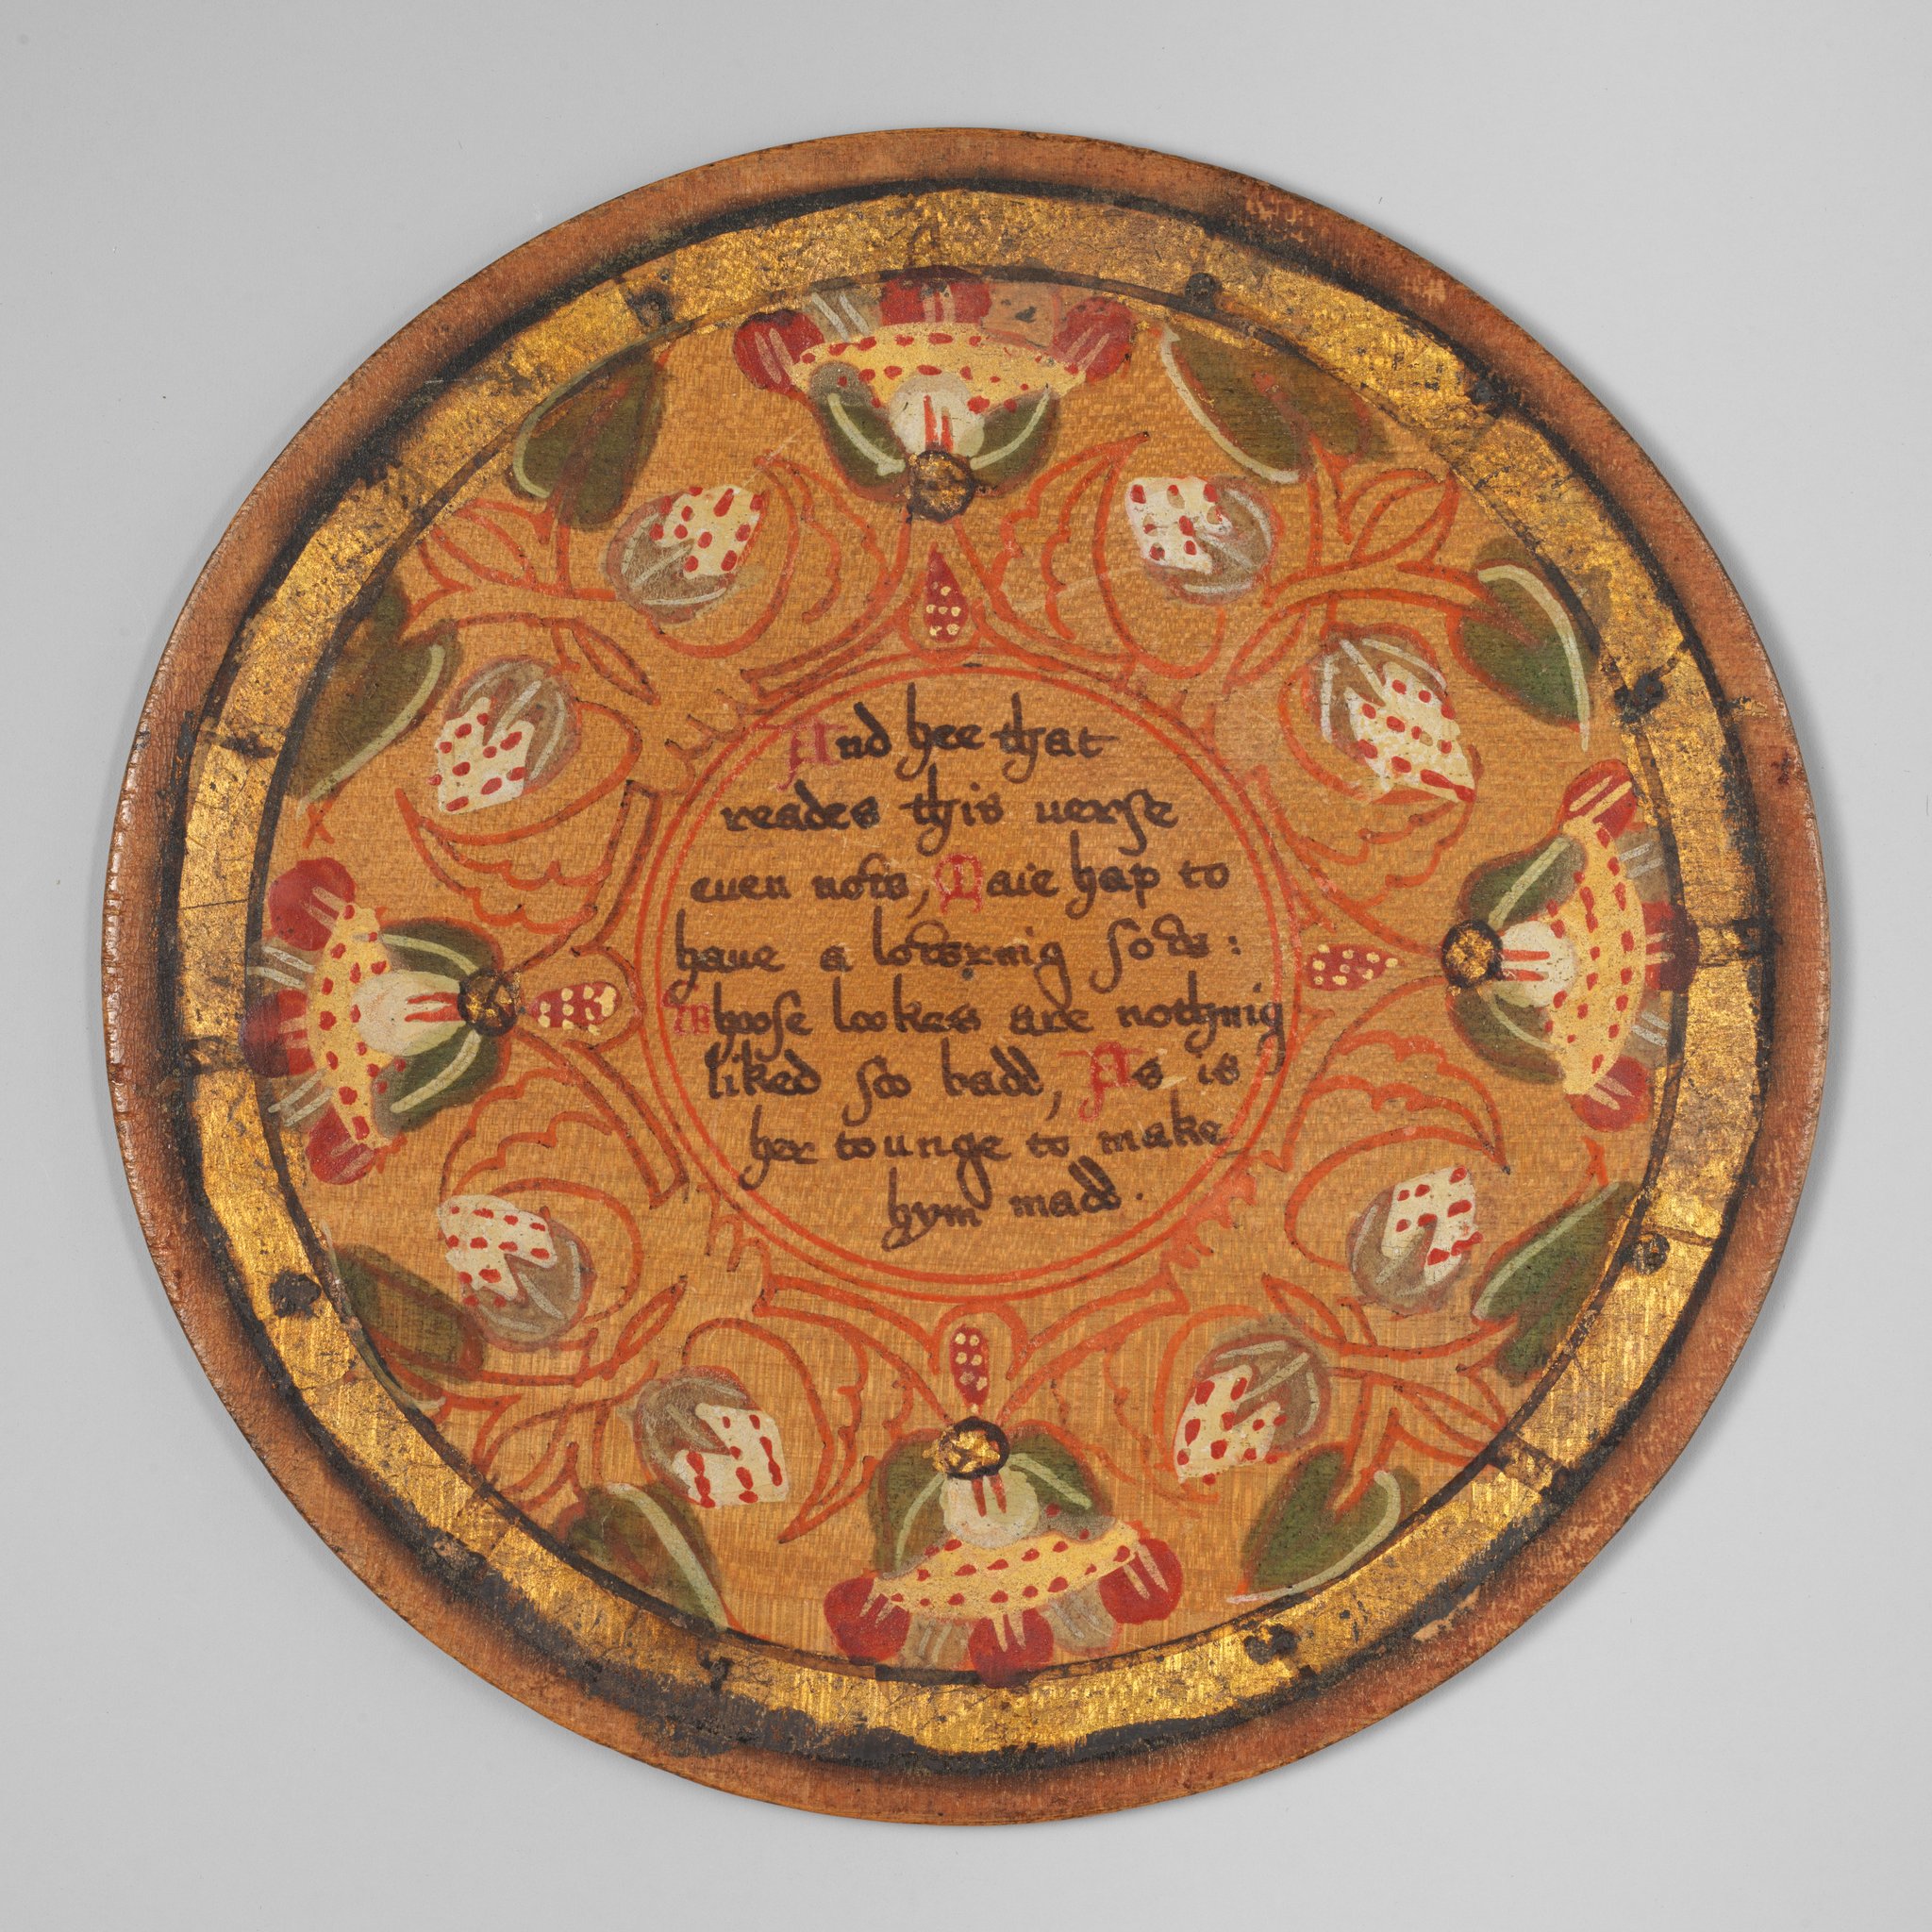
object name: trencher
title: Trencher (one of a set)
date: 1567-1633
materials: ink, wood, varnish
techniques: painting, silvered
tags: flowers